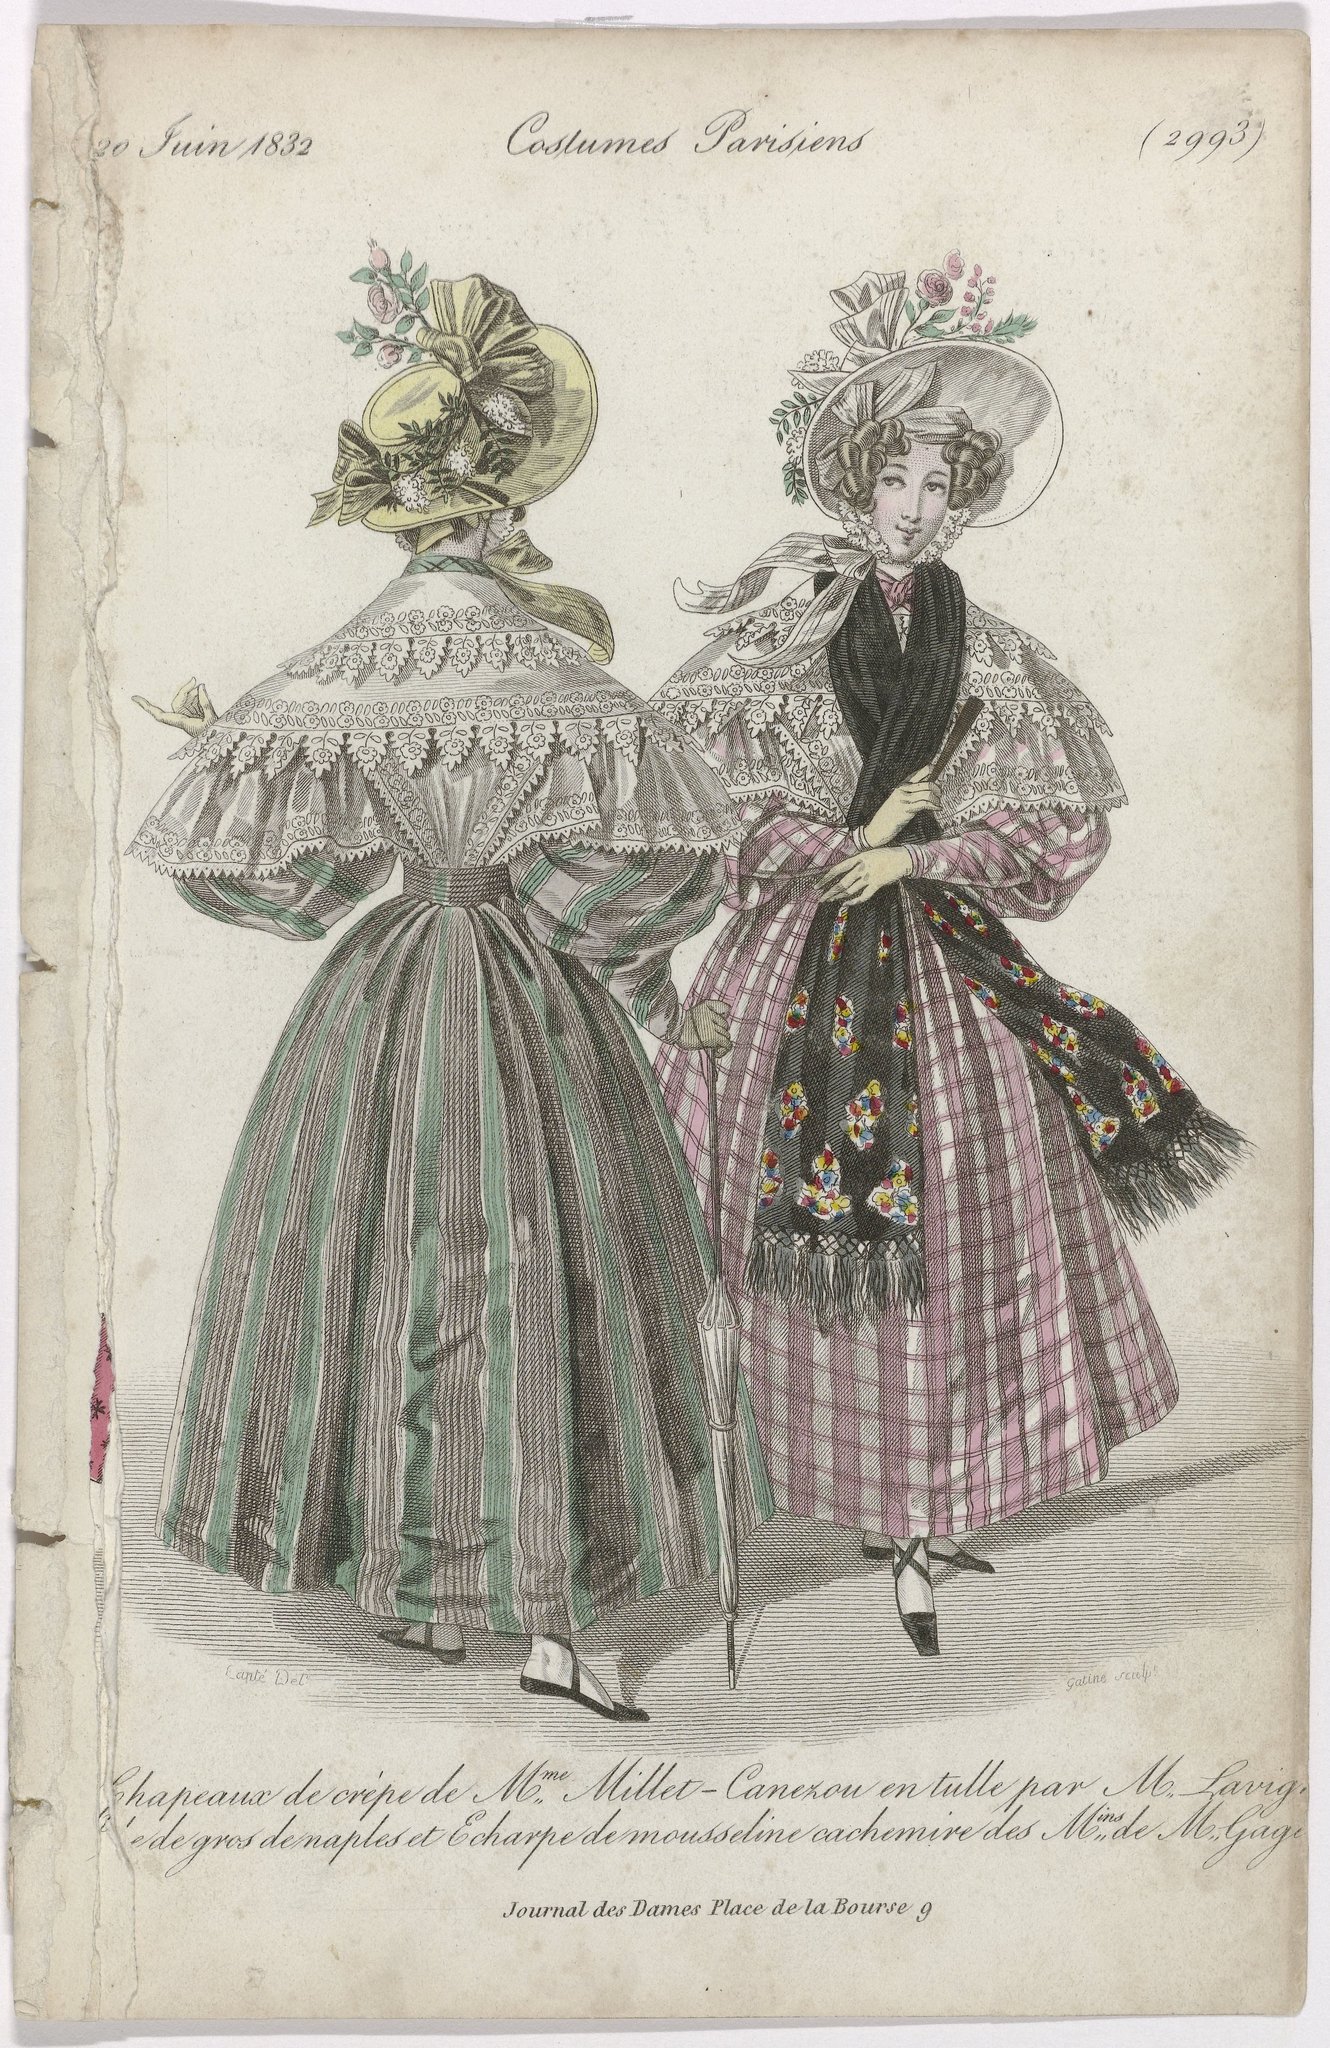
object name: fashion print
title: Journal des Dames et des Modes, Costumes Parisiens, 20 juin 1832, (2993): Chapeaux de crêp (...)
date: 1832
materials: paper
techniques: engraving, hand coloring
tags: clothing for the upper part of the body (shawl) (+ women's clothes), clothing for the upper part of the body: blouse (+ women's clothes), fashion plates, head-gear: hat (+ women's clothes), shoes, sandals (+ women's clothes), dress, gown (+ women's clothes), fan (+ women's clothes), parasol, sunshade (+ women's clothes)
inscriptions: title: ‘Costumes Parisiens.’, address: ‘Journal des Dames Places de la Bourse 9’, caption: ‘Chapeaux de crèpe de M"me Millet-Canezou en tulle par M"Lavig(...). (...)e de gros de naples et Echarpe de mousseline cachemire des M"ins de M"Gage(...)’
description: Hoeden van crêpe van Millet. 'Canezou' van tule, door M Lavig(...).Japon van 'gros de naples' en een sjaal van 'mousseline cachemire' uit de winkels van M Gage(...). Verdere accessoires: waaier, handschoenen, platte schoenen met gekruiste banden en vierkante neuzen. De prent maakt deel uit van het modetijdschrift Journal des Dames et des Modes, Parijs, 1797-1839.